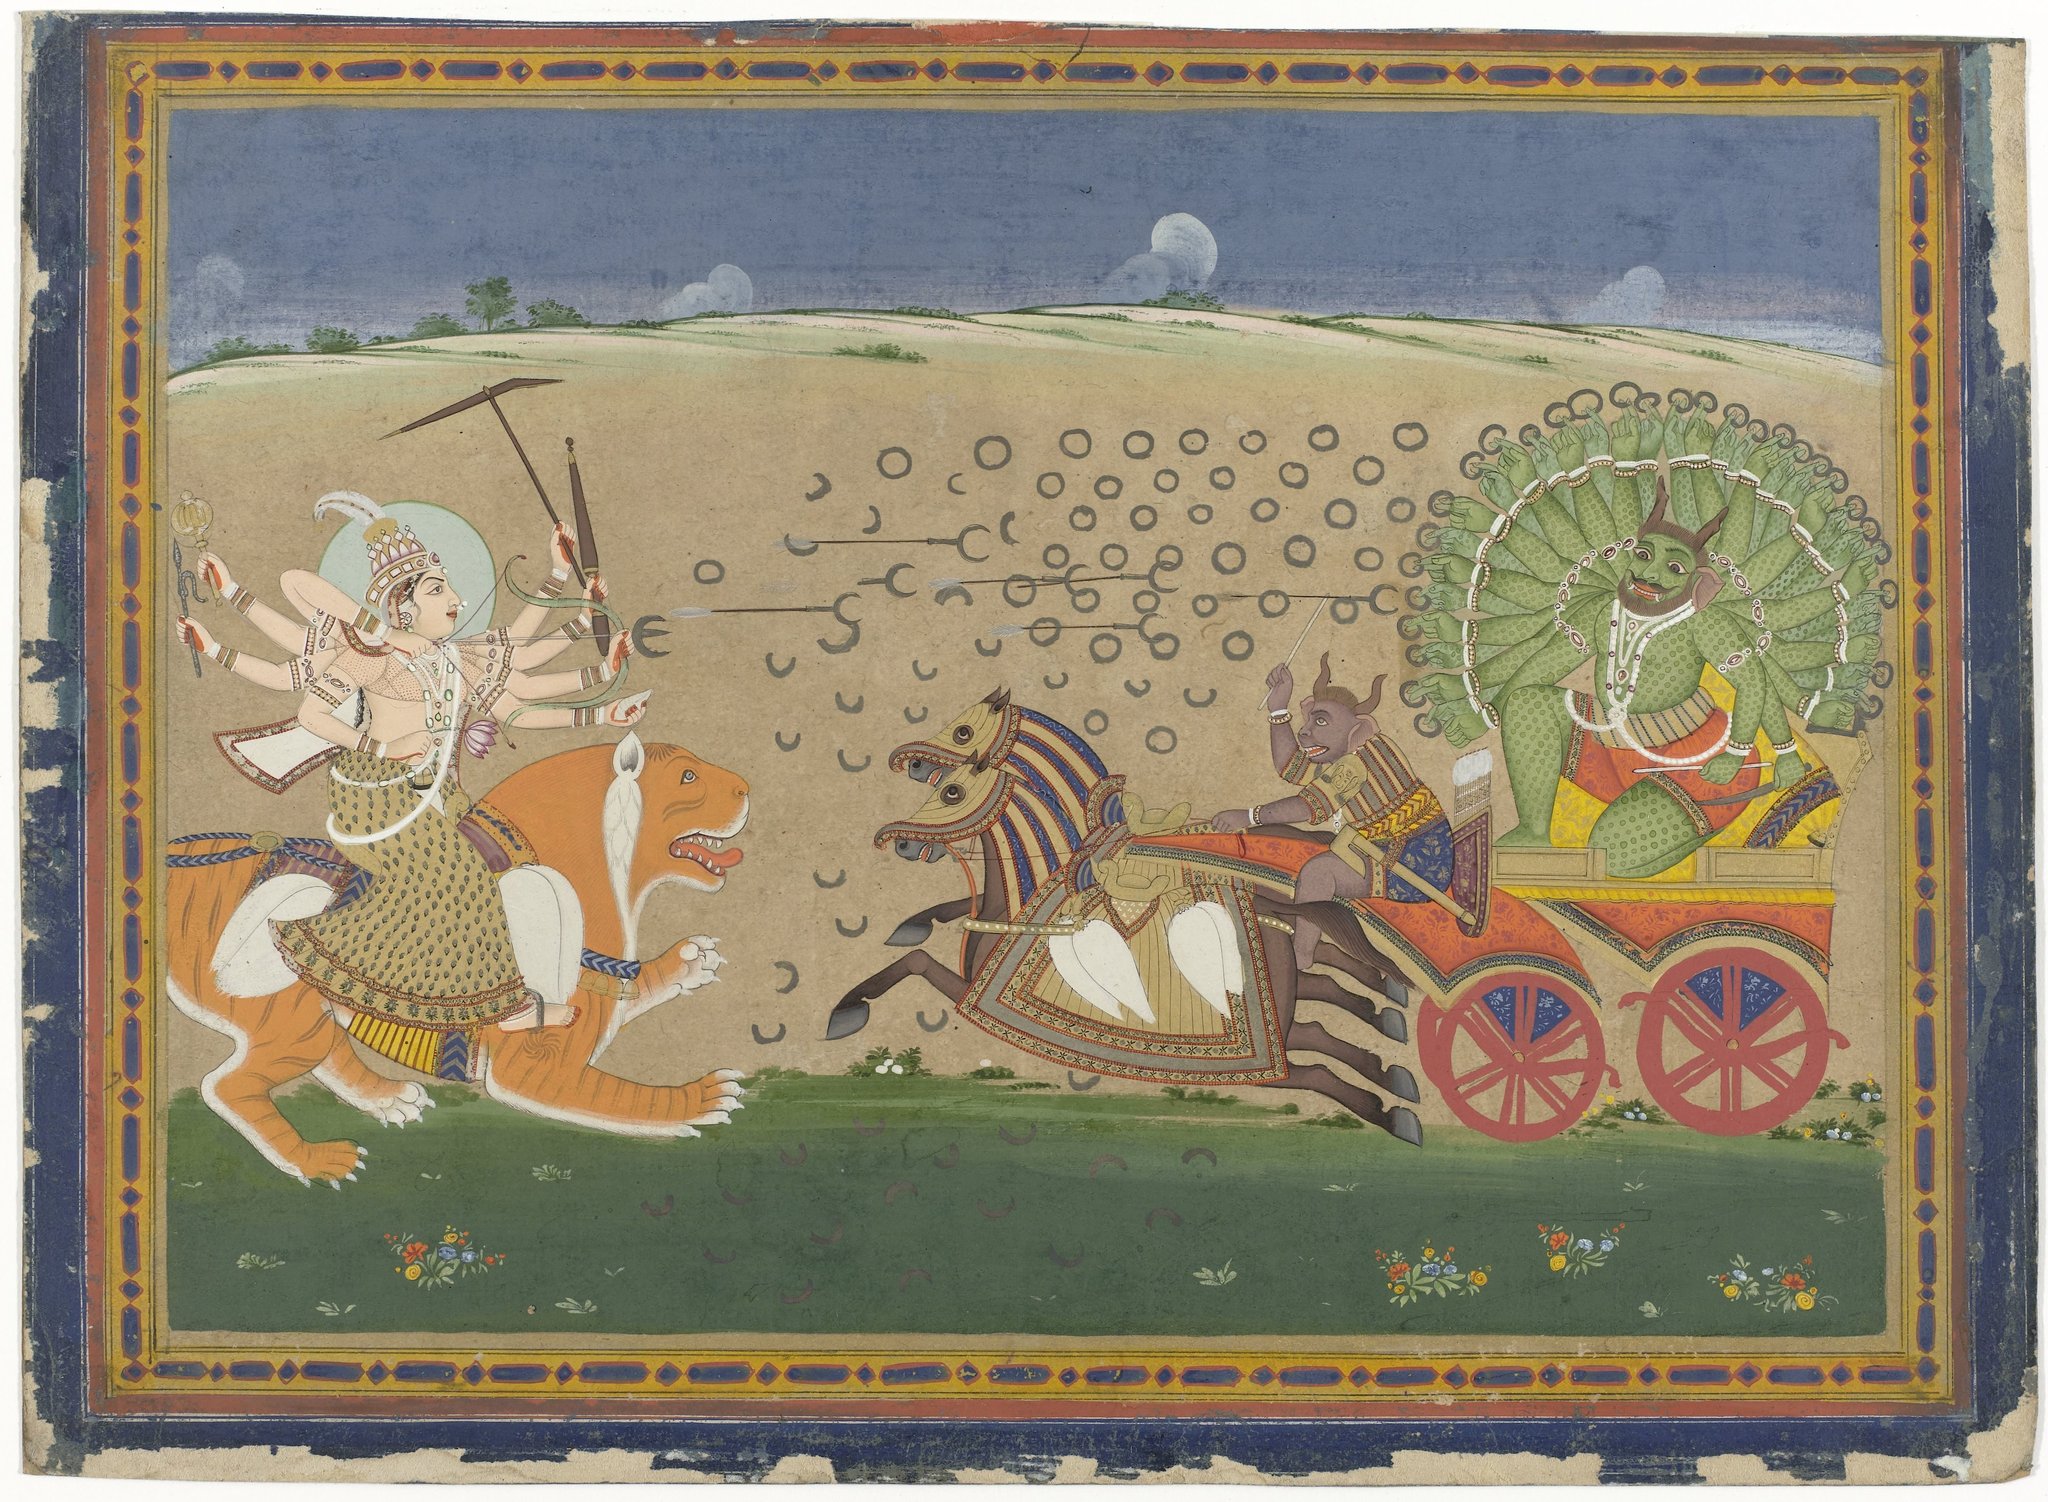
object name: indian miniature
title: Fight between Durga and Nishumbha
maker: Anonymous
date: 1770-1790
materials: paper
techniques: brush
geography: guler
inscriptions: inscription: ‘.’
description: Durga is a principal form of the Great Goddess, known and praised for her victory over demons that threaten the established order of the world. She is often depicted with many arms, holding a variety of weapons and riding a tiger.